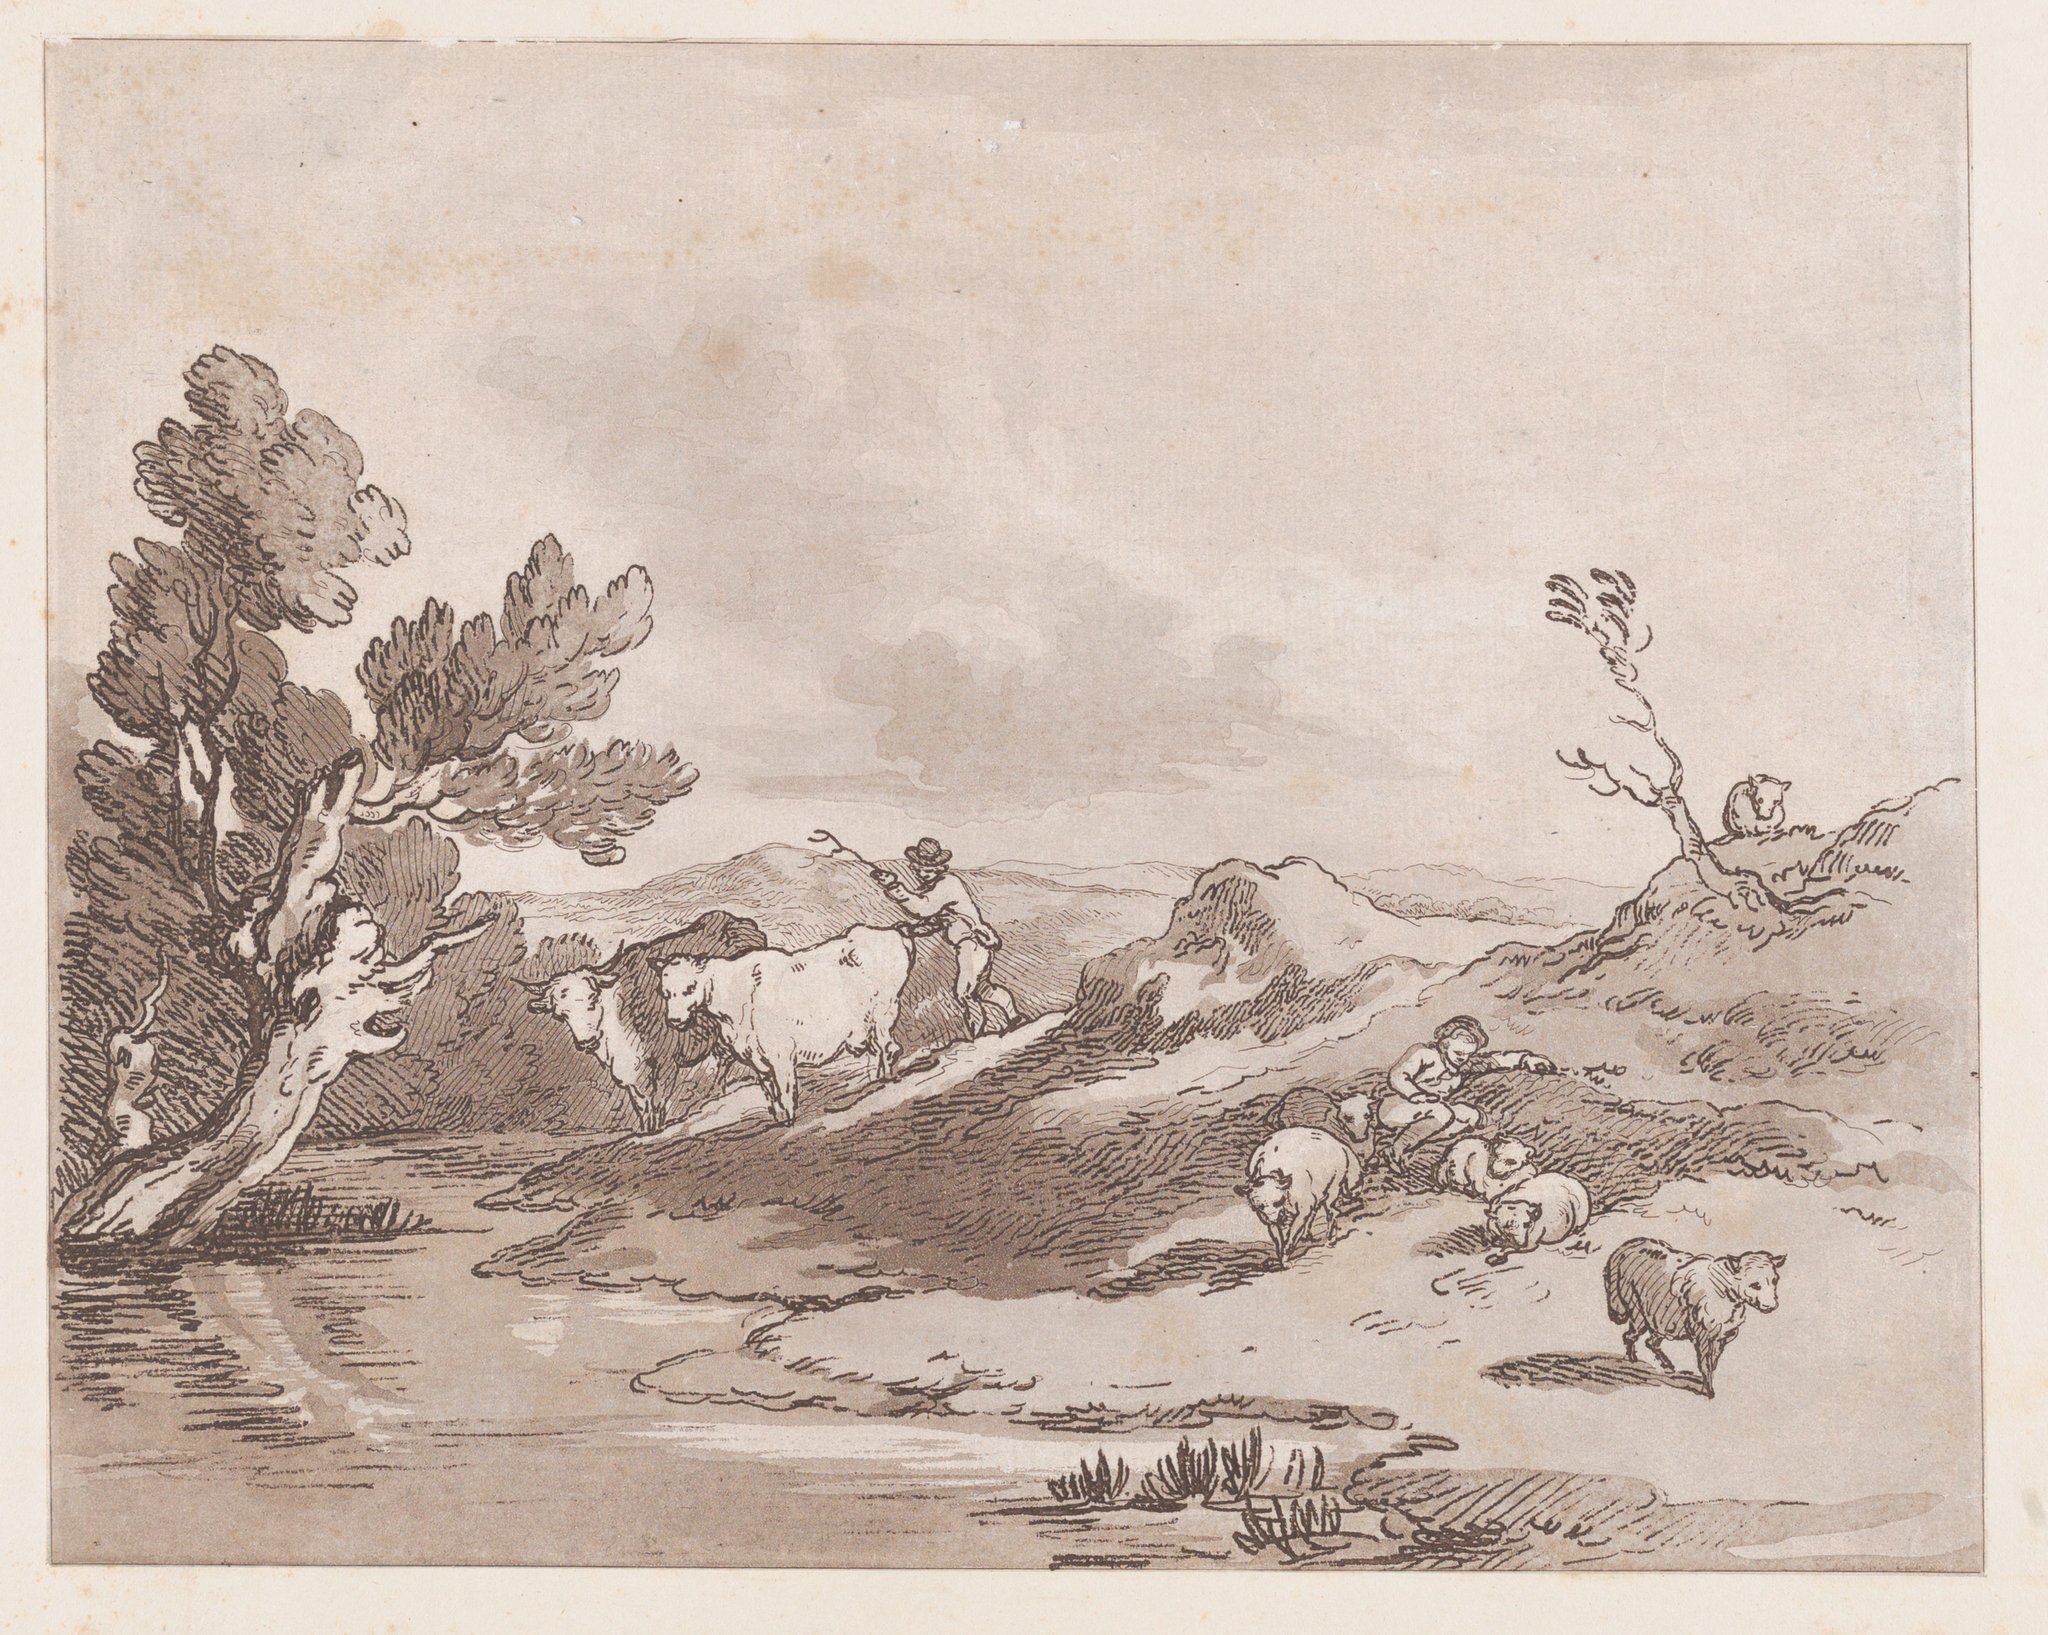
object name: print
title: Landscape with a Figure Herding Cattle to Water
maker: thomas rowlandson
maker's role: artist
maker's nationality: british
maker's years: 1757-1827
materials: ink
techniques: aquatint, etching, printing